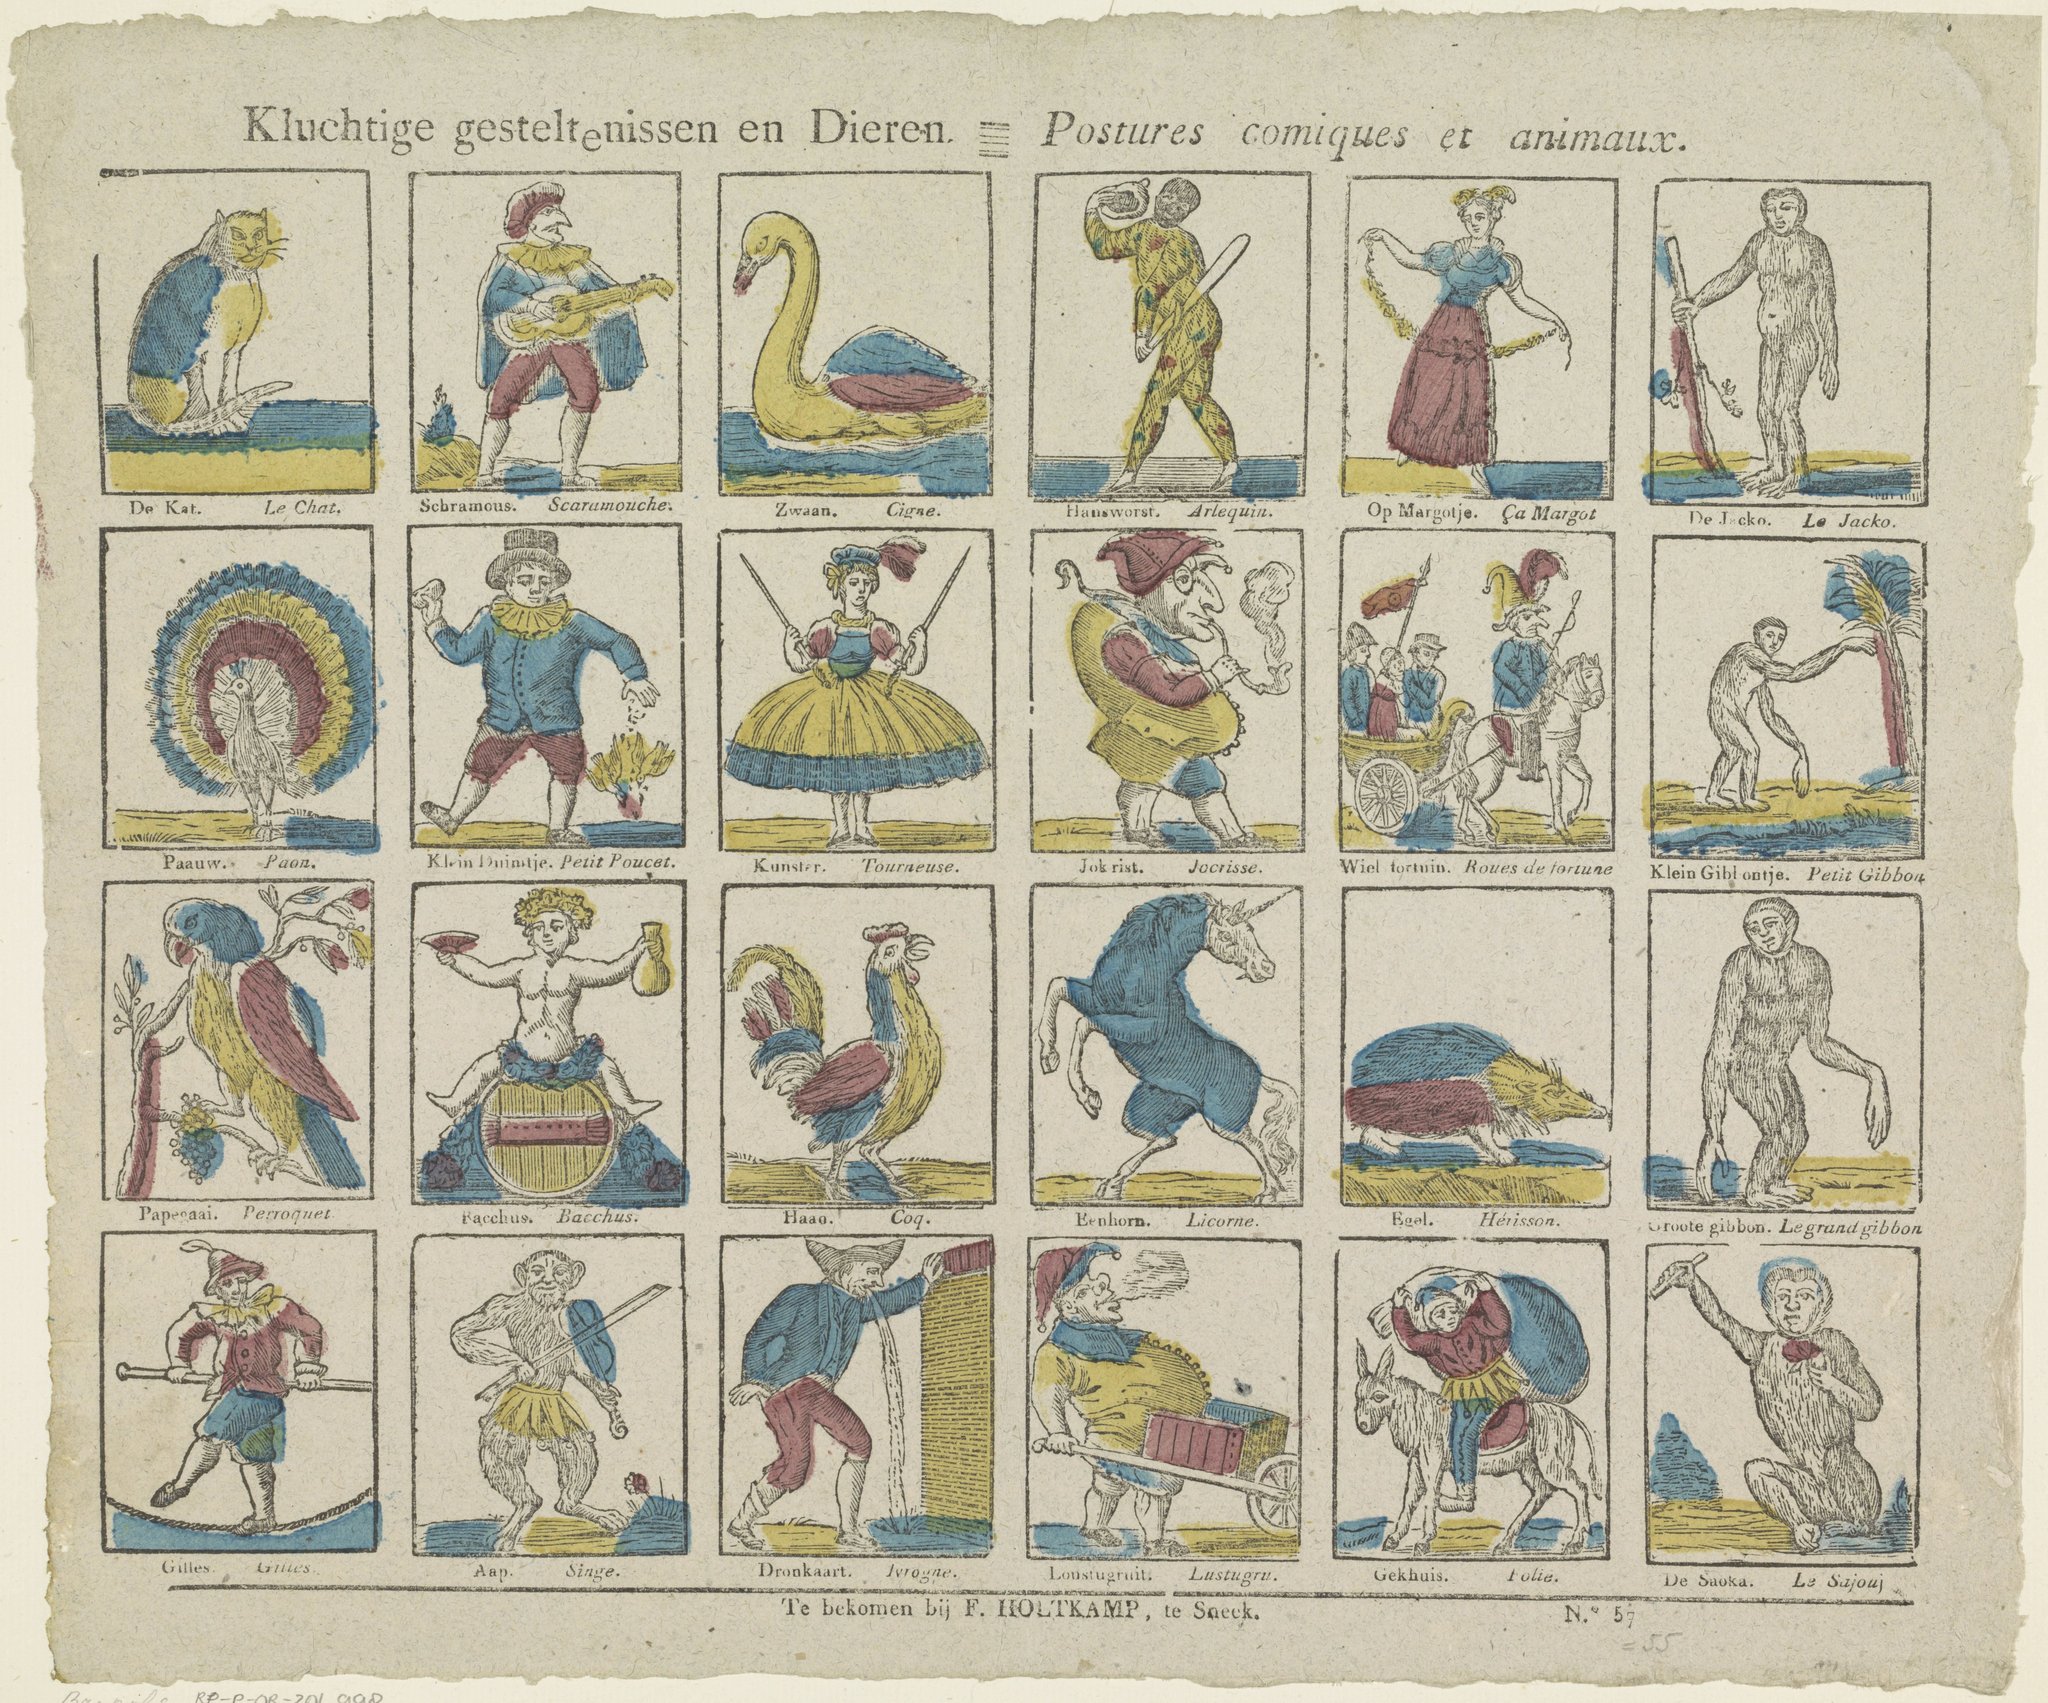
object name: print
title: Kluchtige gesteltenissen en dieren / Postures comiques et animaux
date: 1800-1833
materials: paper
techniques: colour, letterpress printing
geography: turnhout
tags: animals, drunkard, characters (human types), tales and fairy tales: little thumbling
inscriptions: collector's mark: Lugt 2760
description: Blad met 24 voorstellingen van dieren en figuren, waaronder een zwaan, Klein Duimpje en een aap. Onder elke afbeelding een onderschrift in het Nederlands en in het Frans. Genummerd rechtsonder: No. 57.